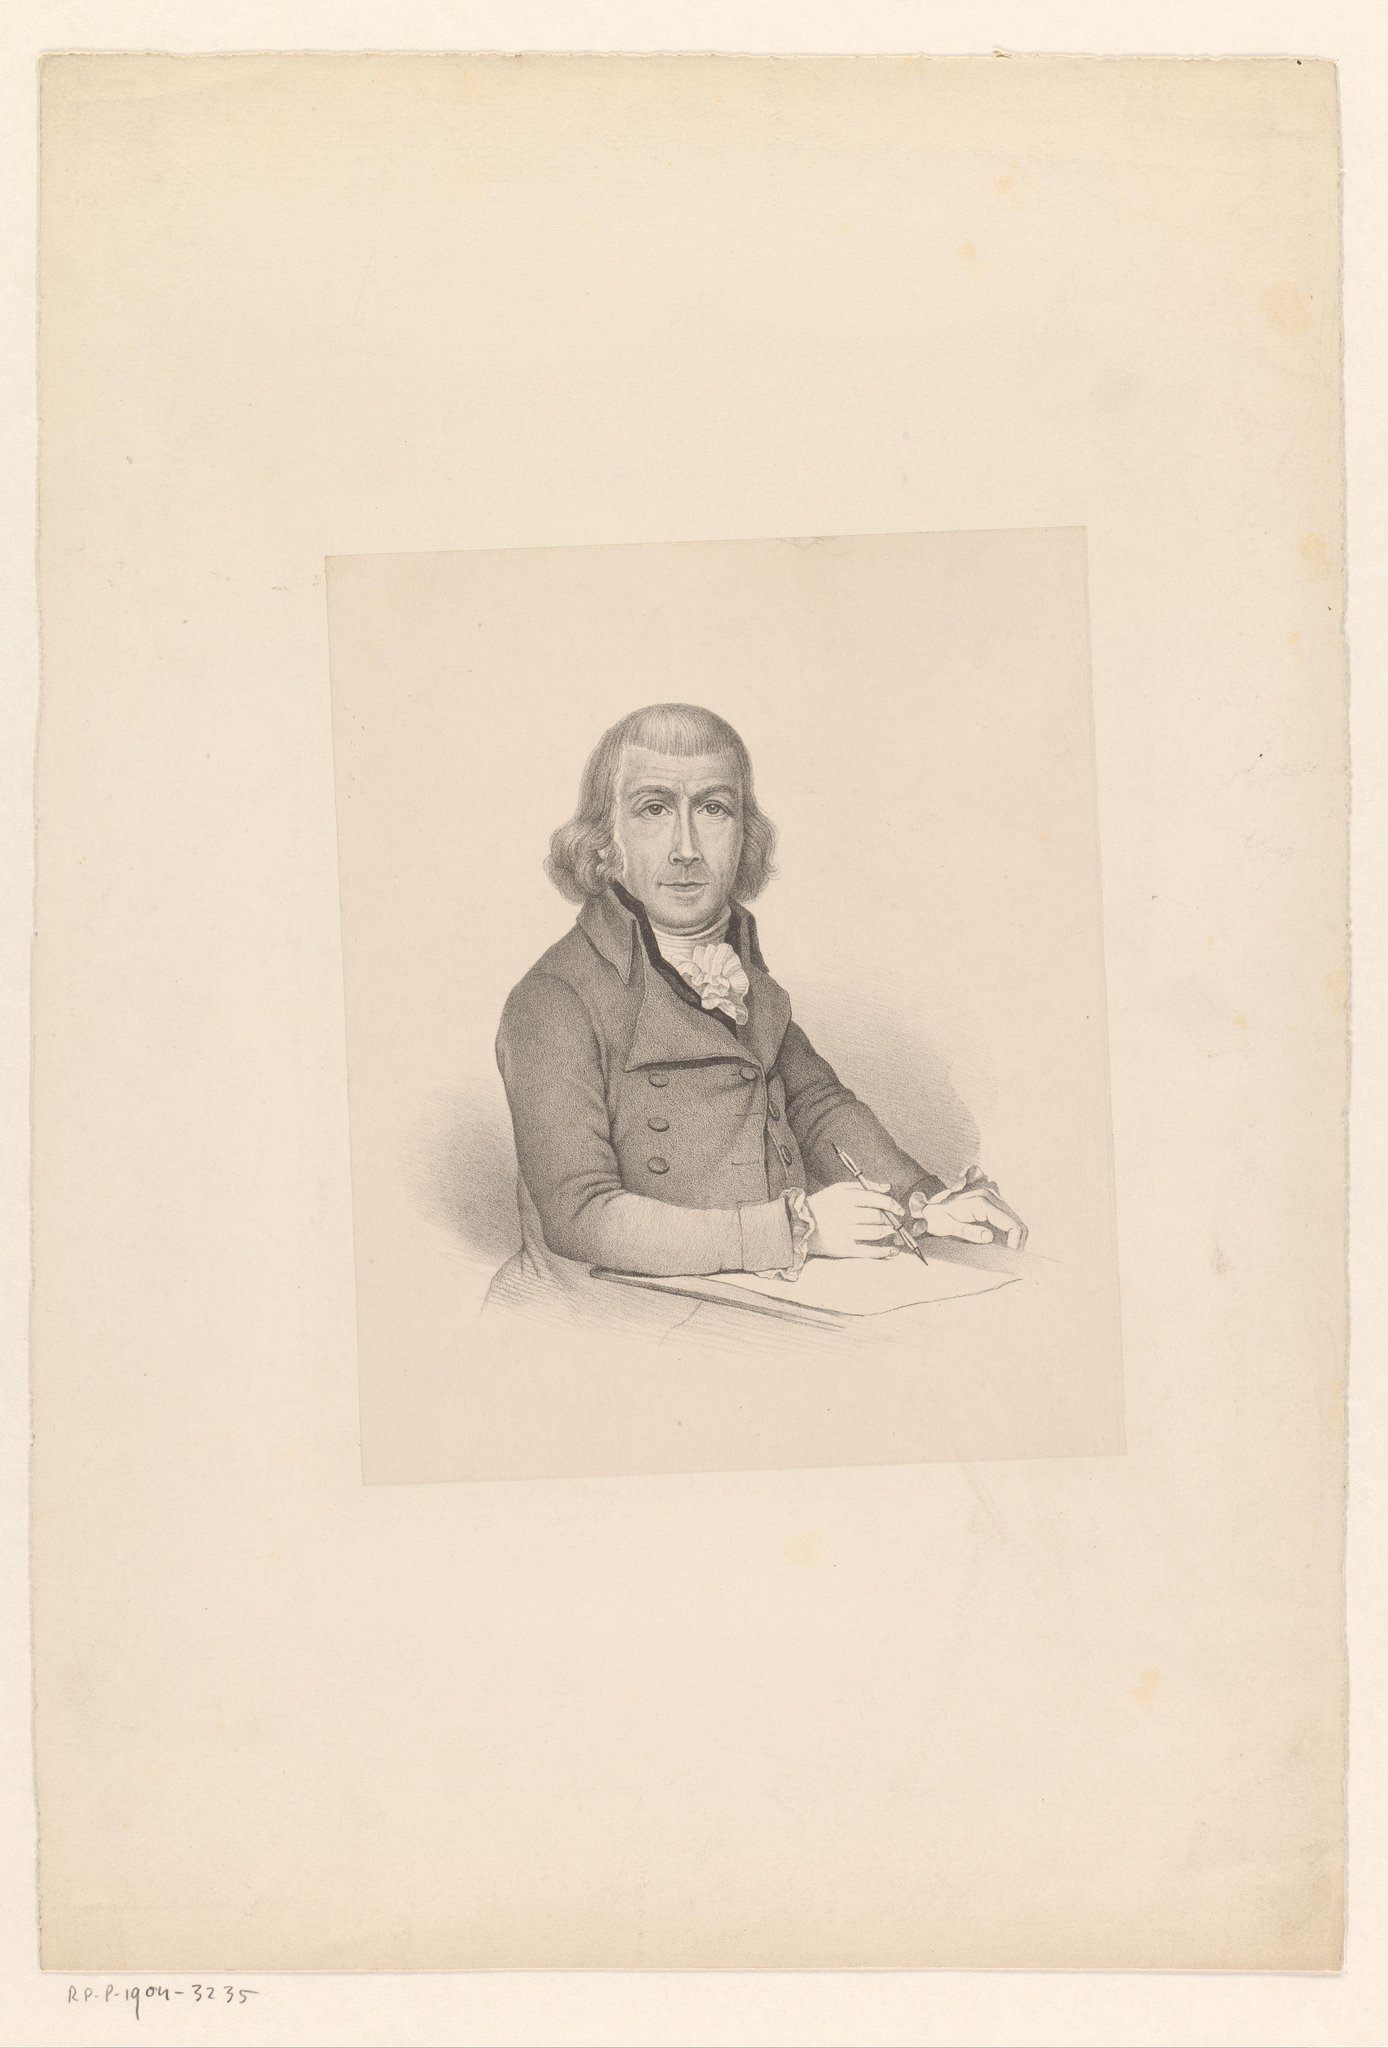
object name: print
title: Portret van een man met een pen boven een vel papier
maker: Anonymous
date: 1810-1850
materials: paper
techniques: lithograph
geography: netherlands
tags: anonymous historical person portrayed alone, pen, paper (writing material)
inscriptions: collector's mark: Lugt 2228